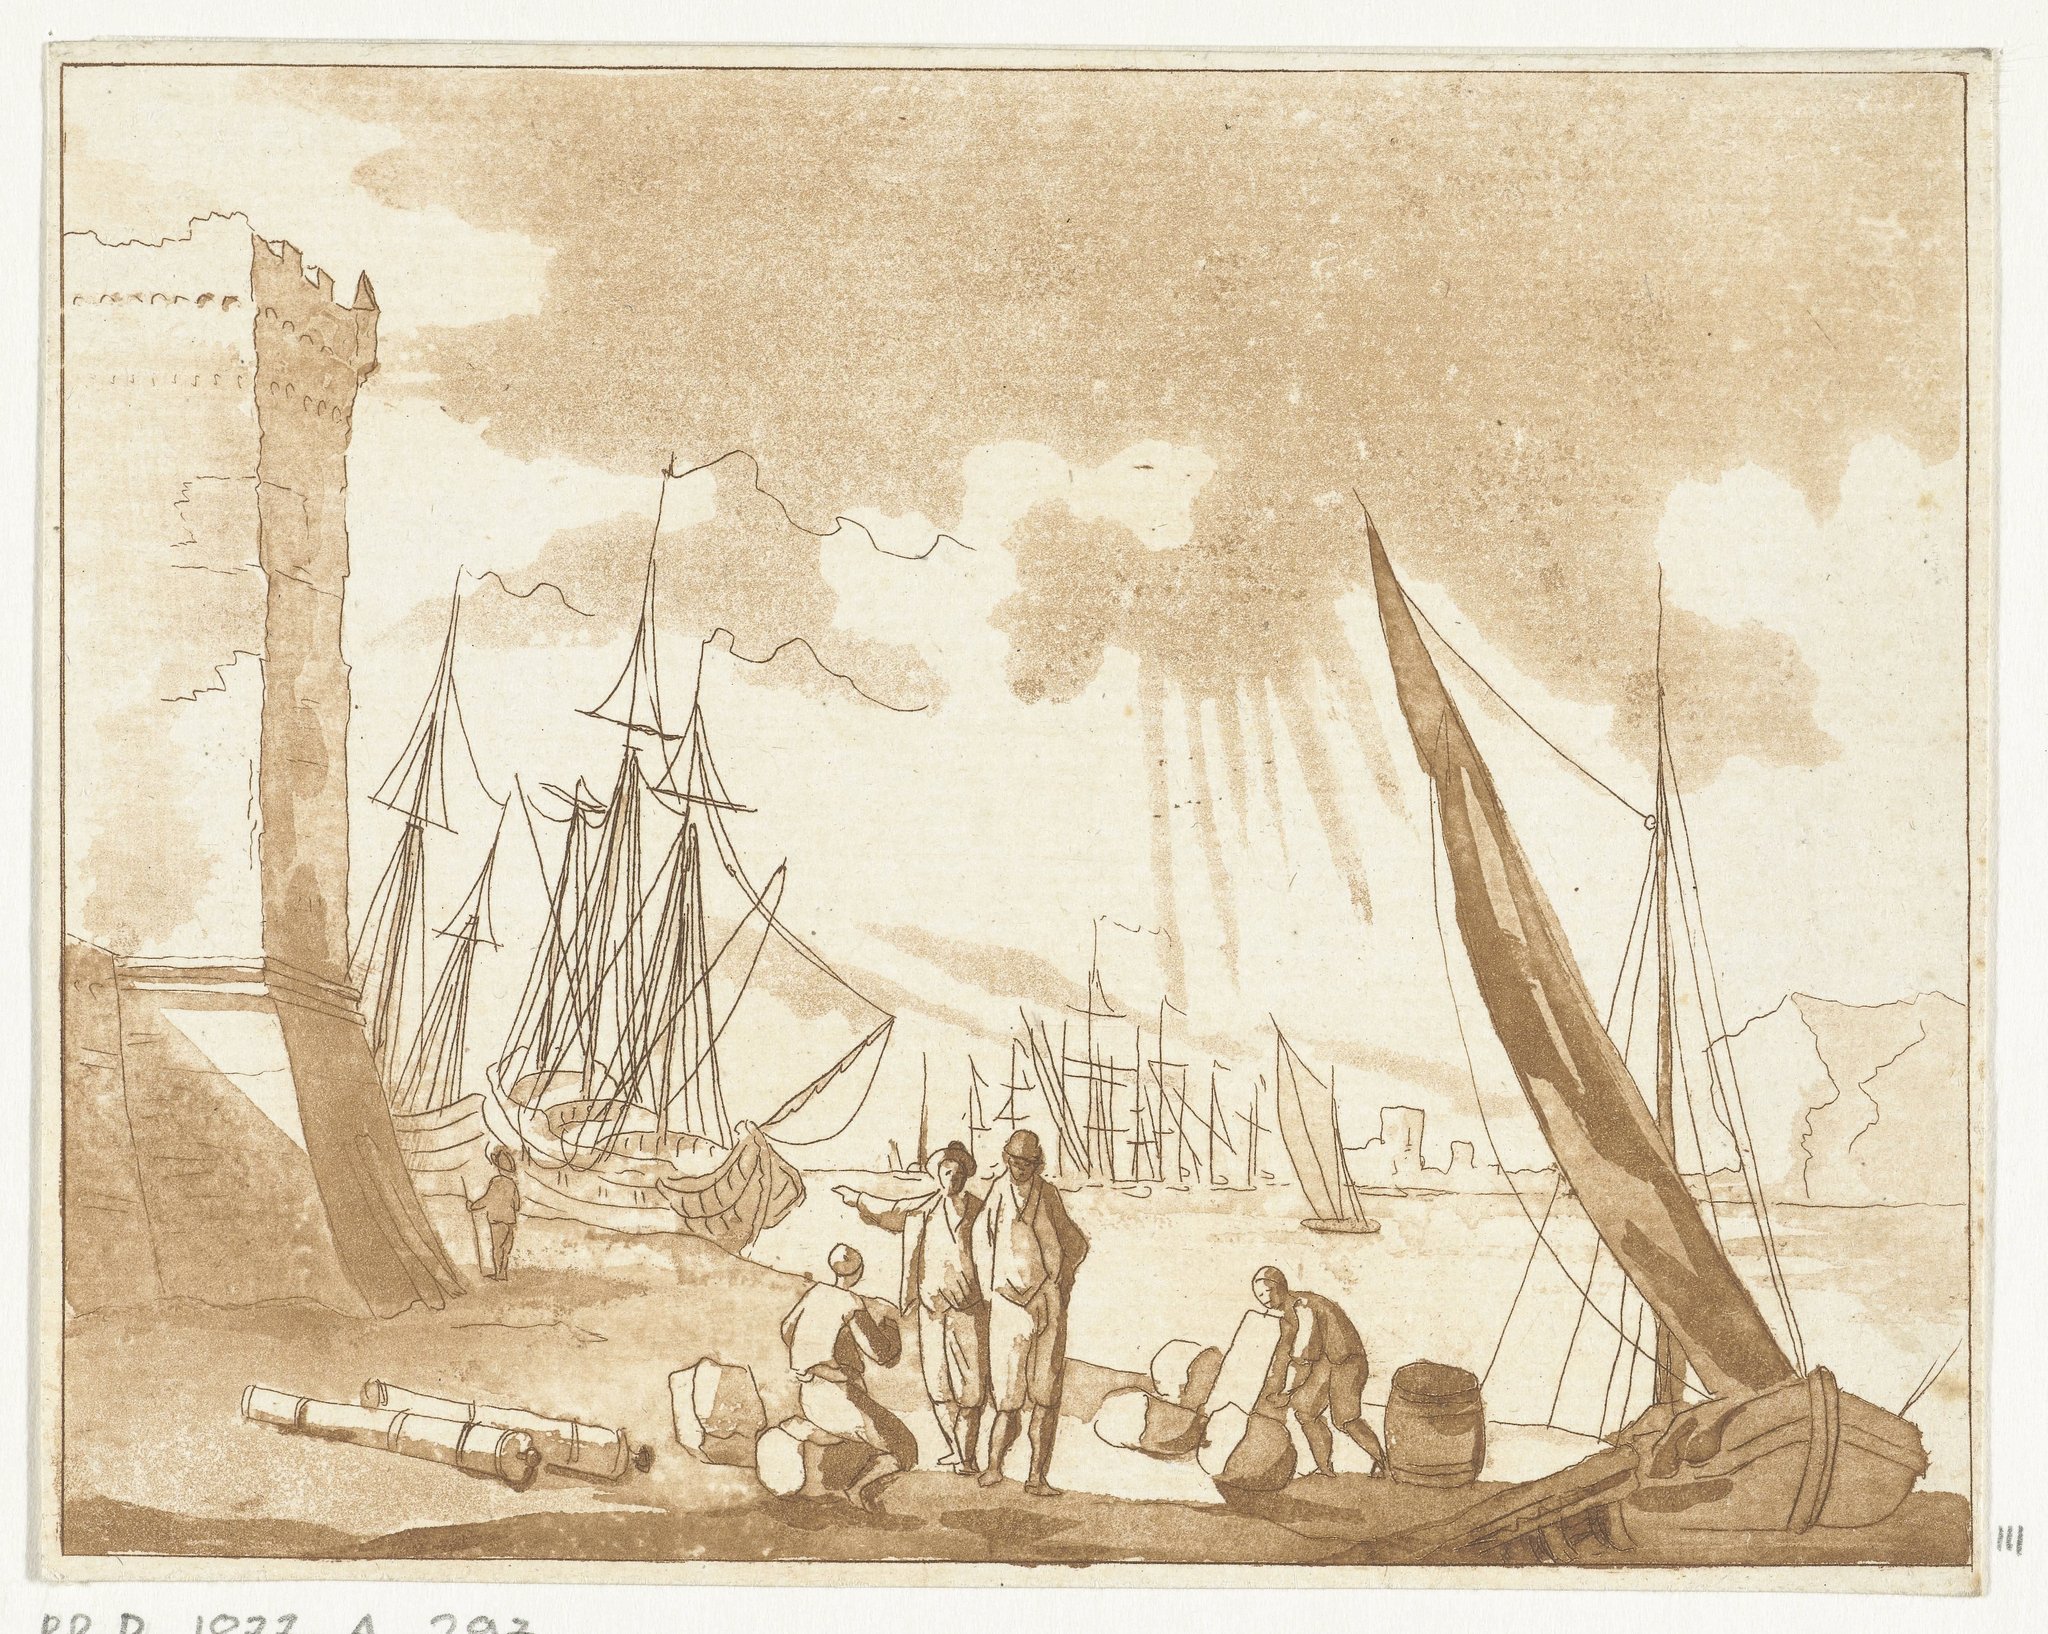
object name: print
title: Havengezicht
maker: anthonie van den bos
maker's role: draughtsman, print maker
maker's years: 1763-1838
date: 1778-1838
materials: paper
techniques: aquatint, etching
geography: netherlands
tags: harbour, pier, quay, wharf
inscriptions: collector's mark: Lugt 2228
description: Drie mannen staan op de kade van een haven vlakbij een toren te praten. Een vierde man brengt lading vanuit een aan de kade aangemeerd schip aan land.